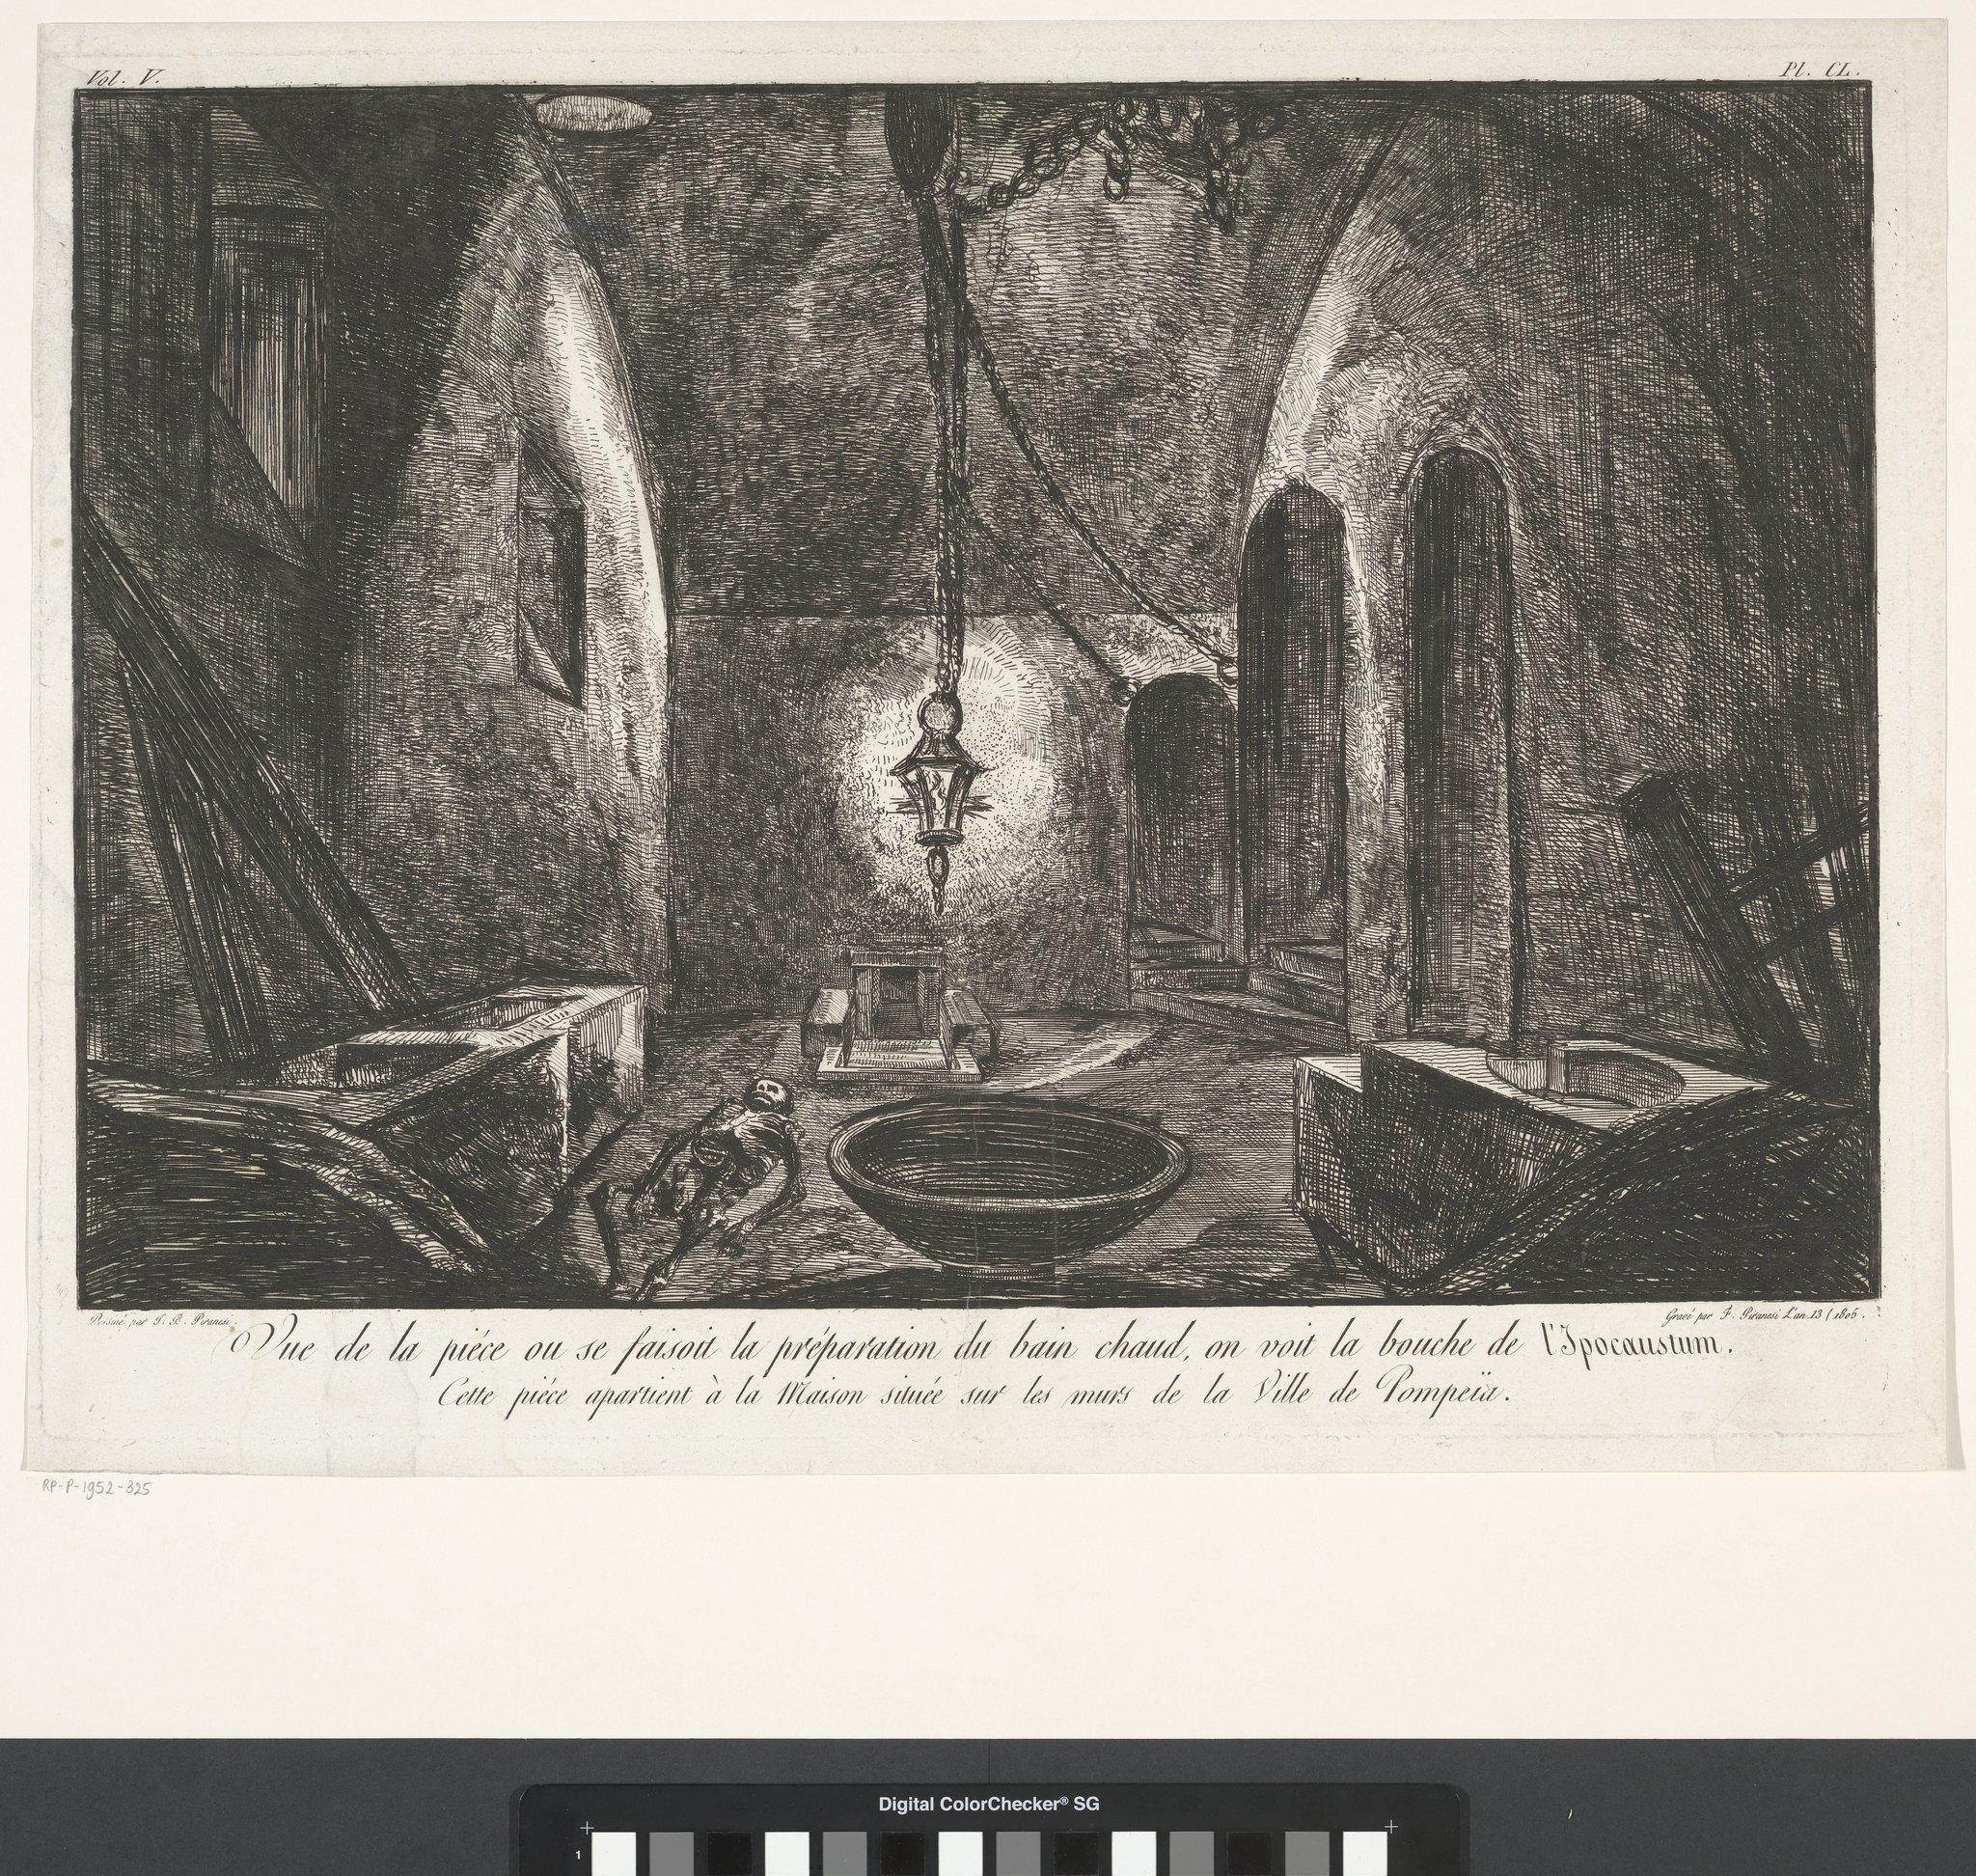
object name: print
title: Hypocaustum in Pompeï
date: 1805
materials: paper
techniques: etching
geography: italy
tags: grave, tomb, (human) skeleton, basement, cellar, cellar, pompeii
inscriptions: date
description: Gezicht in een hypocaustum of een grafkelder te Pompeï. Onderschrift in het Italiaans in ondermarge. Genummerd linksboven: Vol. V., rechtsboven: Pl. CL.